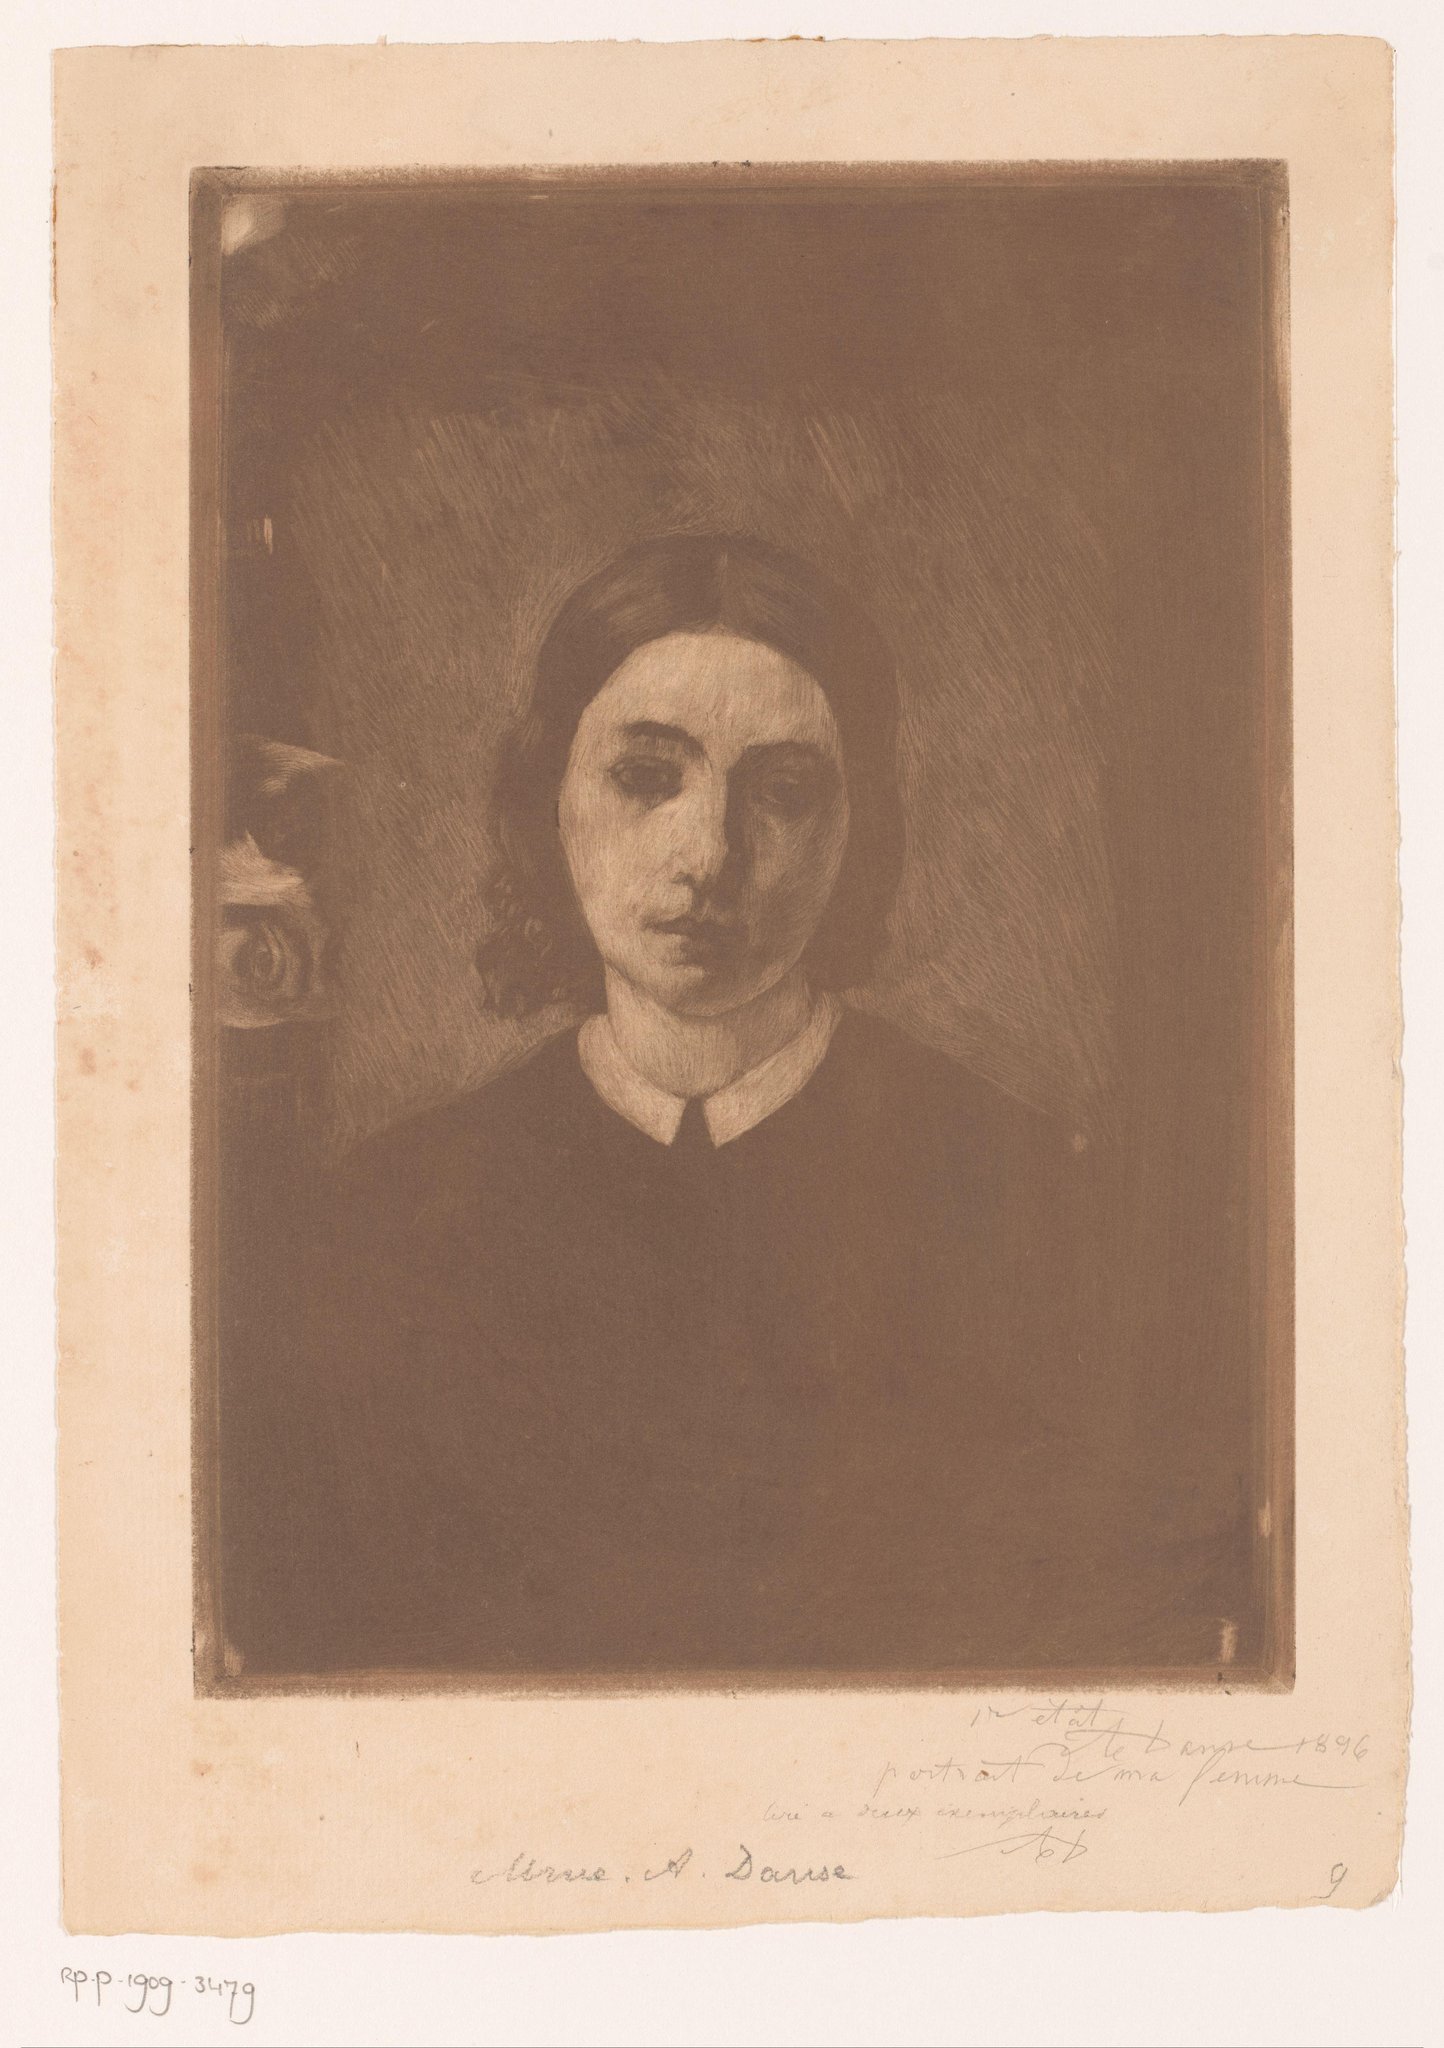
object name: print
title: Portrait de ma femme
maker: auguste danse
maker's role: print maker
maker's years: 1829-1929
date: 1896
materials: paper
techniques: aquatint, etching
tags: historical person (with name) - bb - woman - historical person (with name) portrayed alone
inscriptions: collector's mark: Lugt 2228, annotation: ‘1er état; tiré a deux exemplaires’